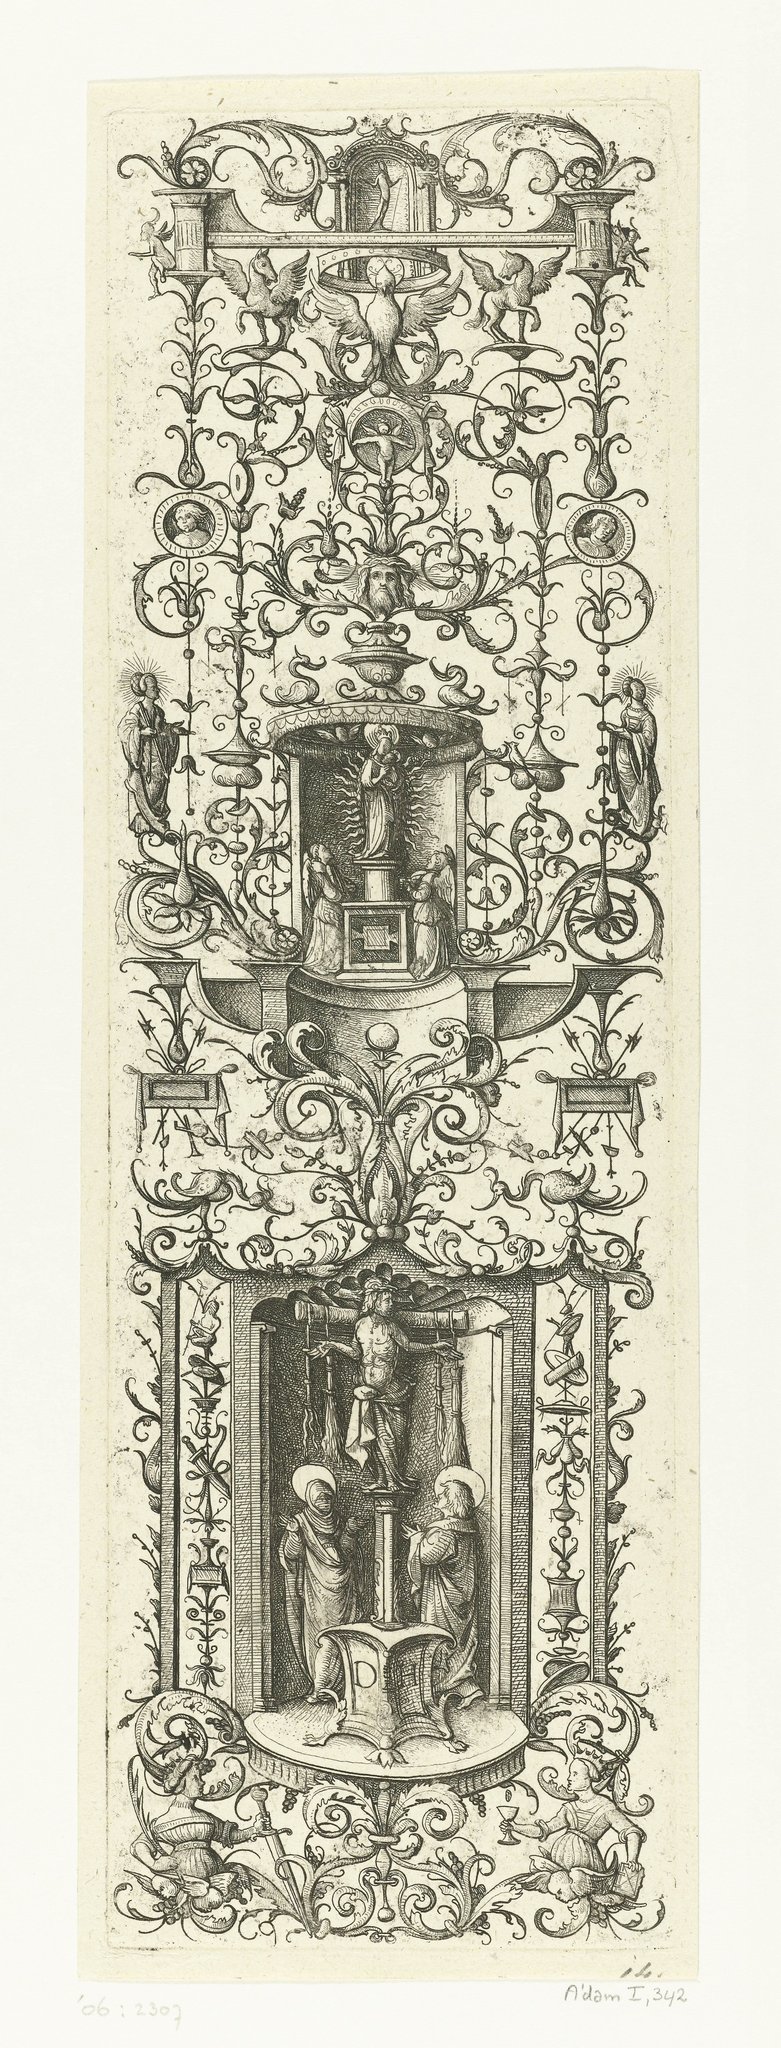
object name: ornament print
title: Vlakdecoratie met onderaan de Kruisiging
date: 1480-1536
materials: paper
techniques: etching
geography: germany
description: In het midden de aanbidding van Maria omgeven door bladranken en grotesken.